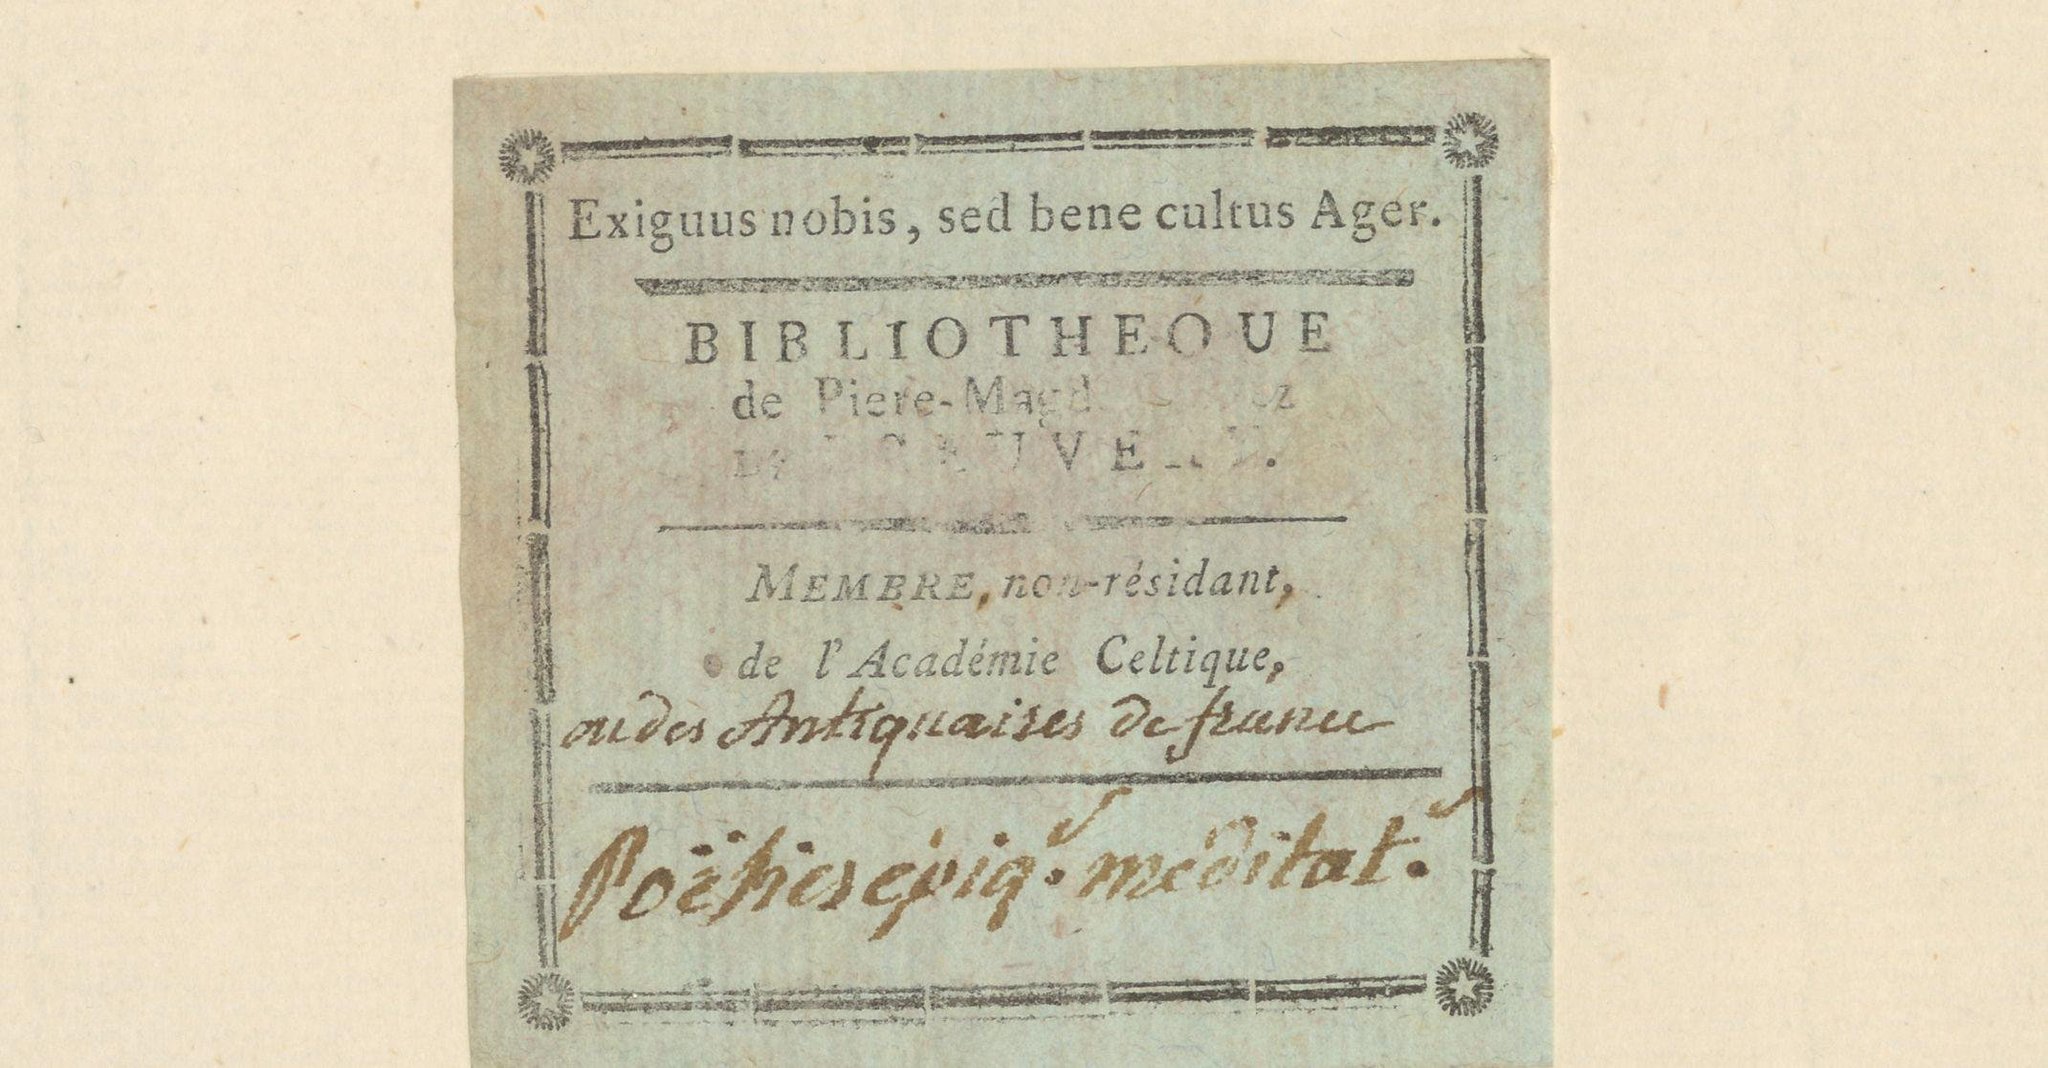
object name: bookplate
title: Exiguus nobis, sed bene cultus Ager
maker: Anonymous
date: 1804-1813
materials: paper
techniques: letterpress printing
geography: france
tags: académie celtique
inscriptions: collector's mark: Lugt 2233, collector's mark: Lugt 2760, inscription: ‘ou des Antiquaires de france / Poësies épiq. mèditat.’